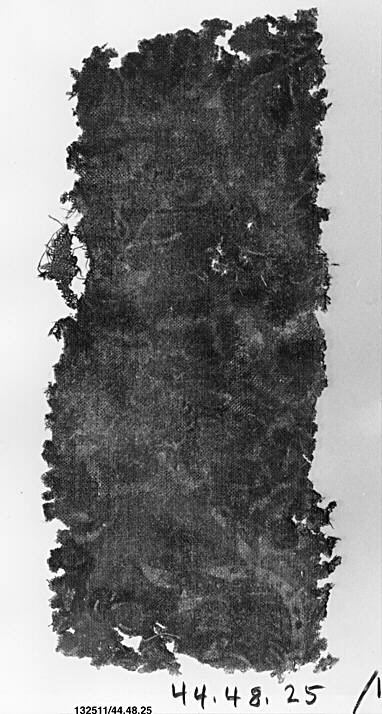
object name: fragment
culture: japanese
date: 701-800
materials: cotton, linen